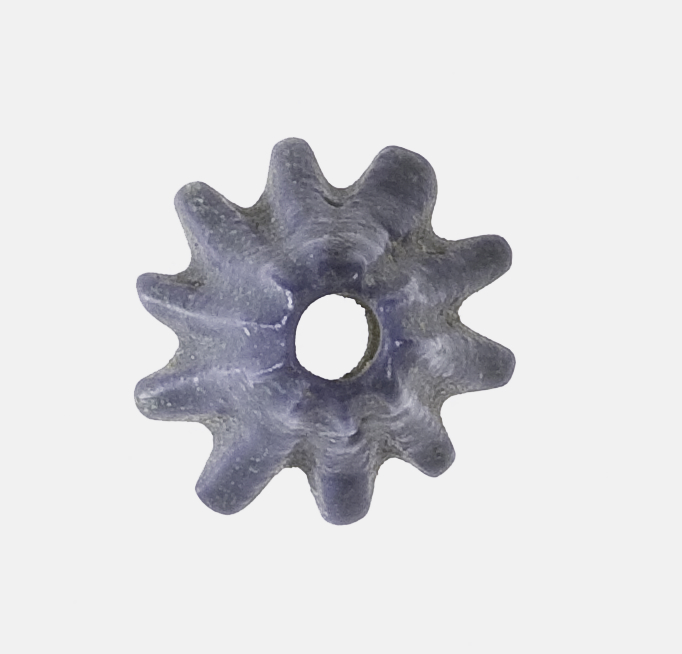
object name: pendant, cornflower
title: Pendant: Petals of Cornflower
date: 1390-1352 BCE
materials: faience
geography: egypt